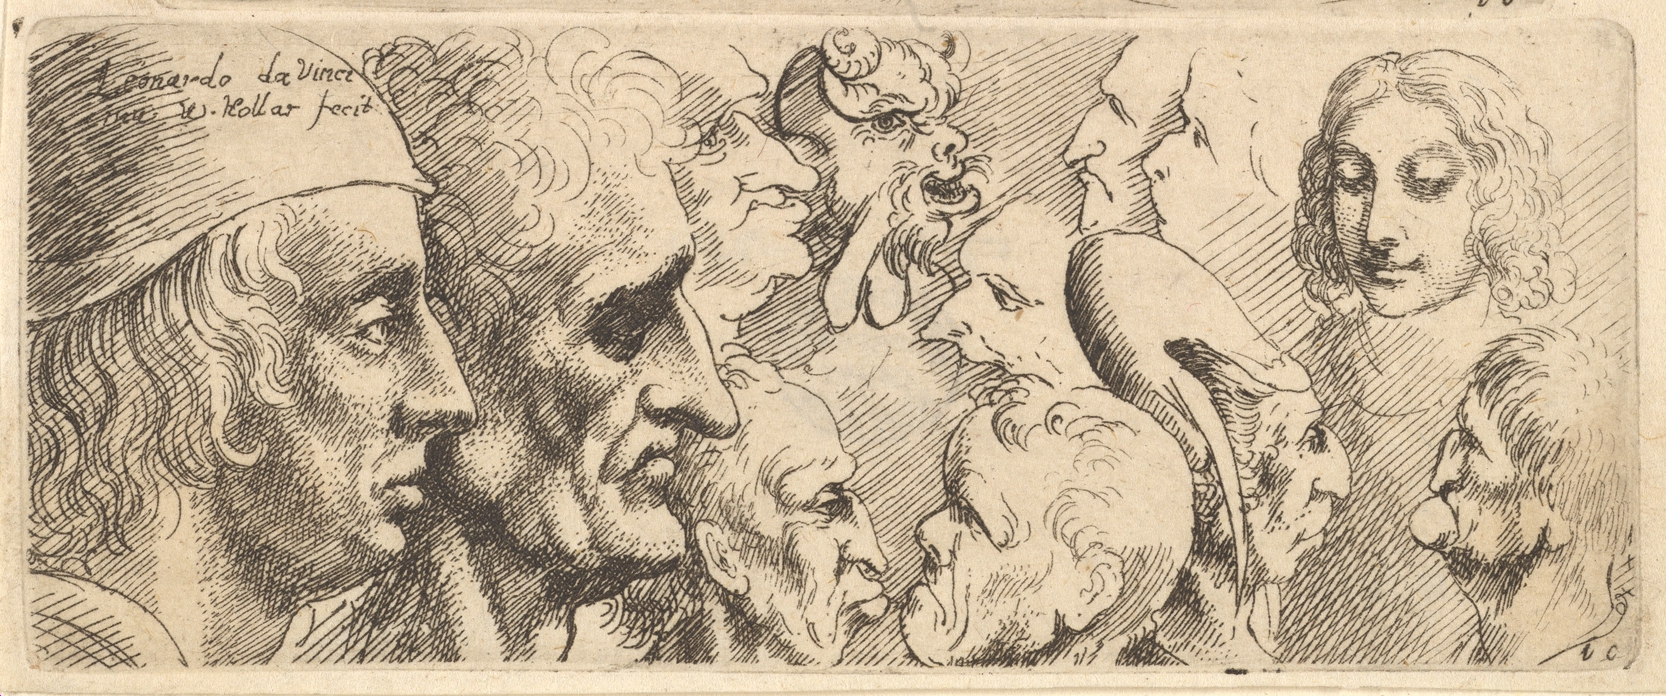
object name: print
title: A variety of heads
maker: wenceslaus hollar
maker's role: artist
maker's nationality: bohemian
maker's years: 1607-1677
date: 1645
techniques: etching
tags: heads,men,profiles